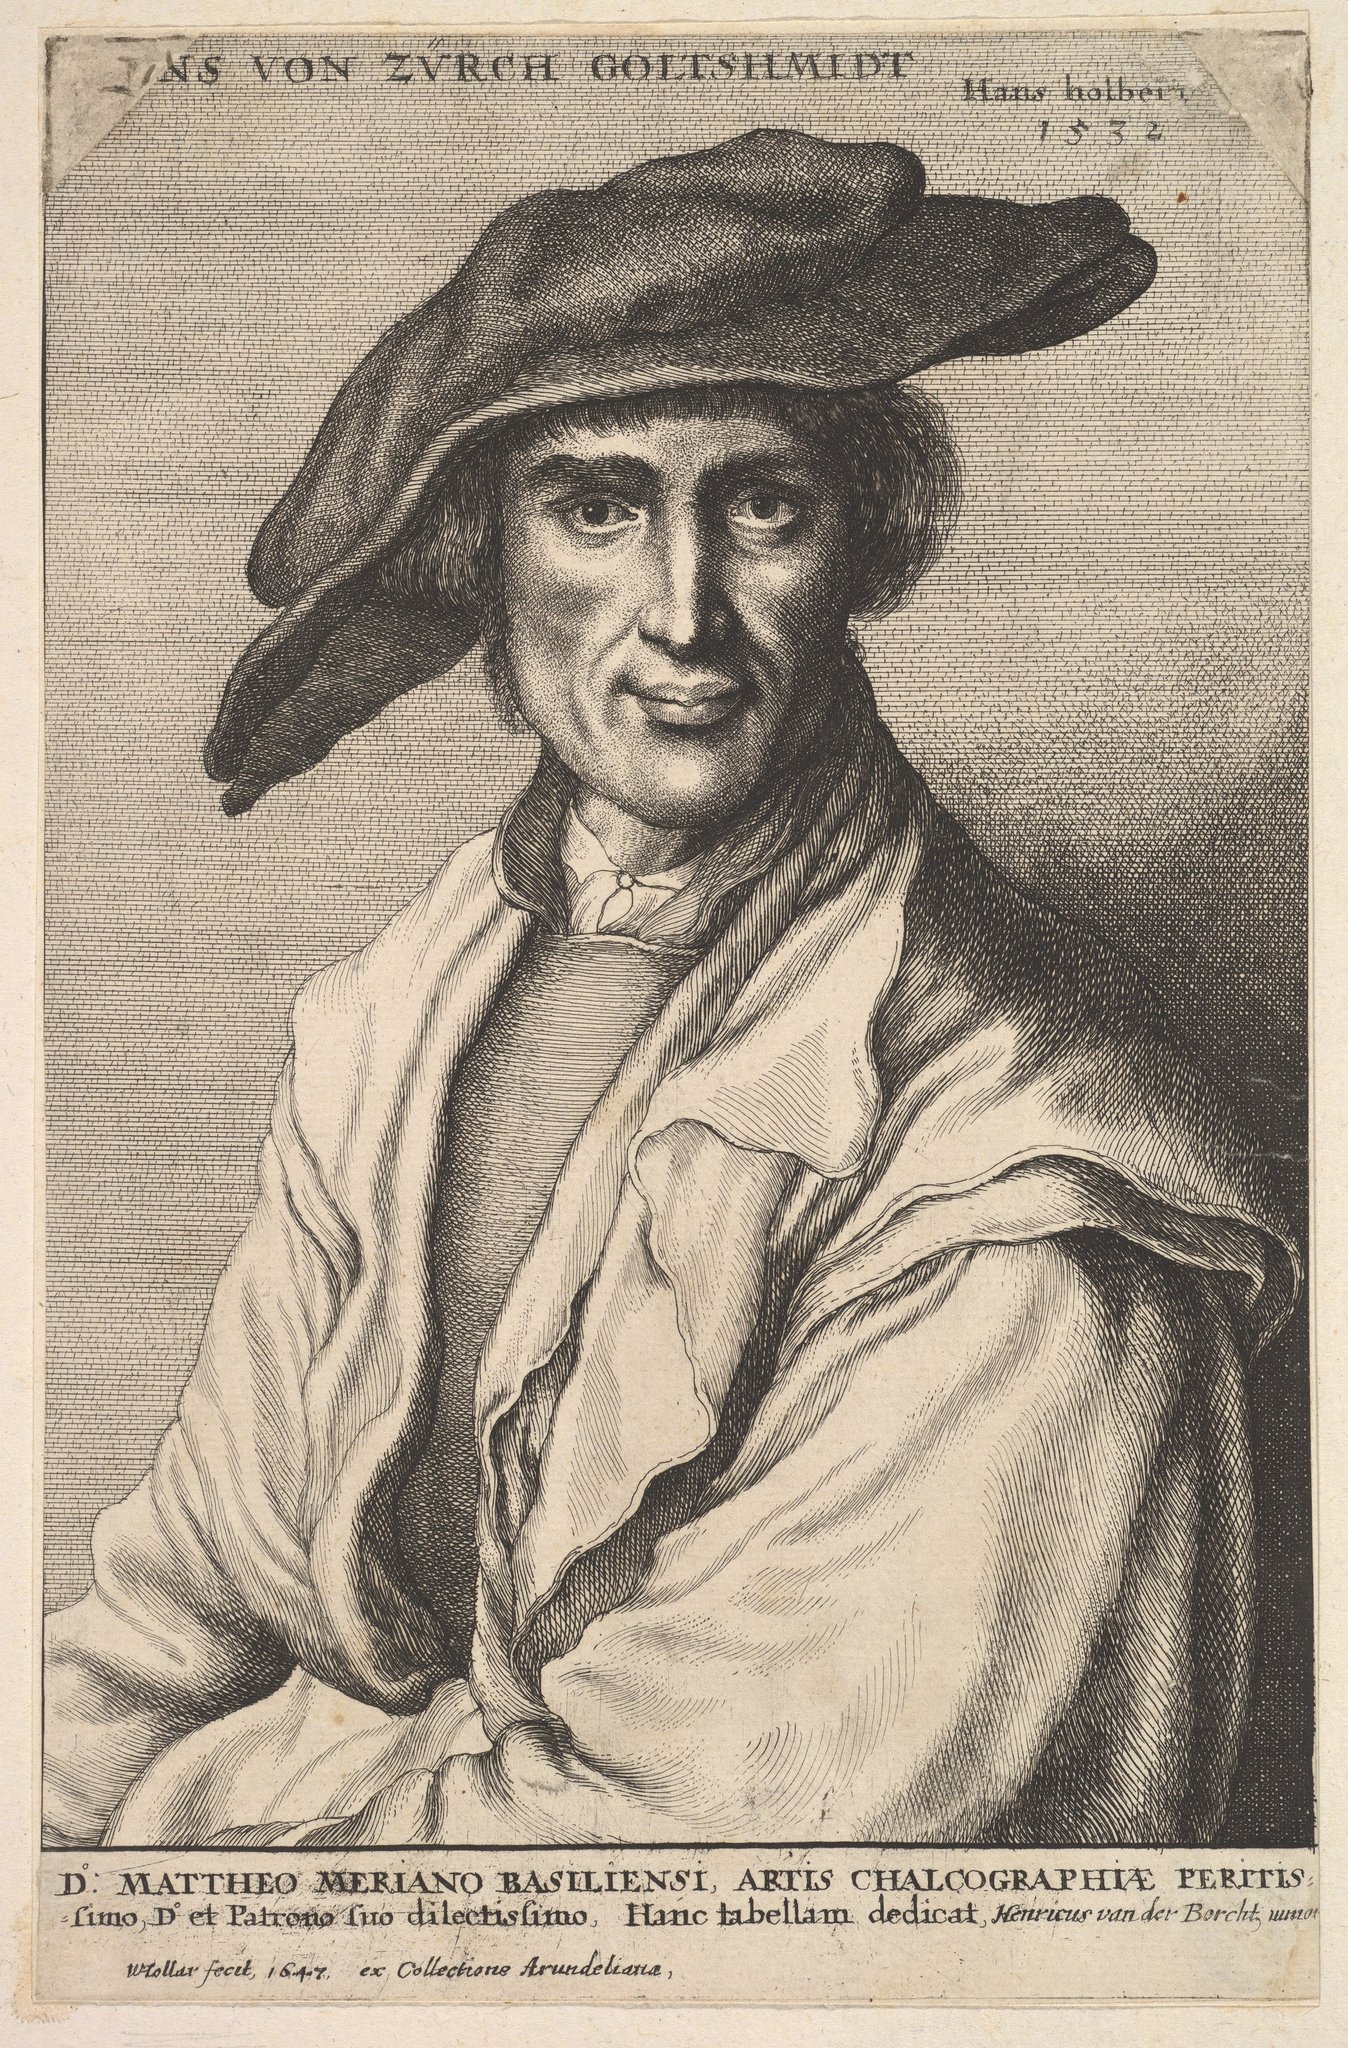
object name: print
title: Hans von Zürch Goltshmidt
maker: wenceslaus hollar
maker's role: artist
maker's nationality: bohemian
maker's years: 1607-1677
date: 1647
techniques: etching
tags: men,portraits